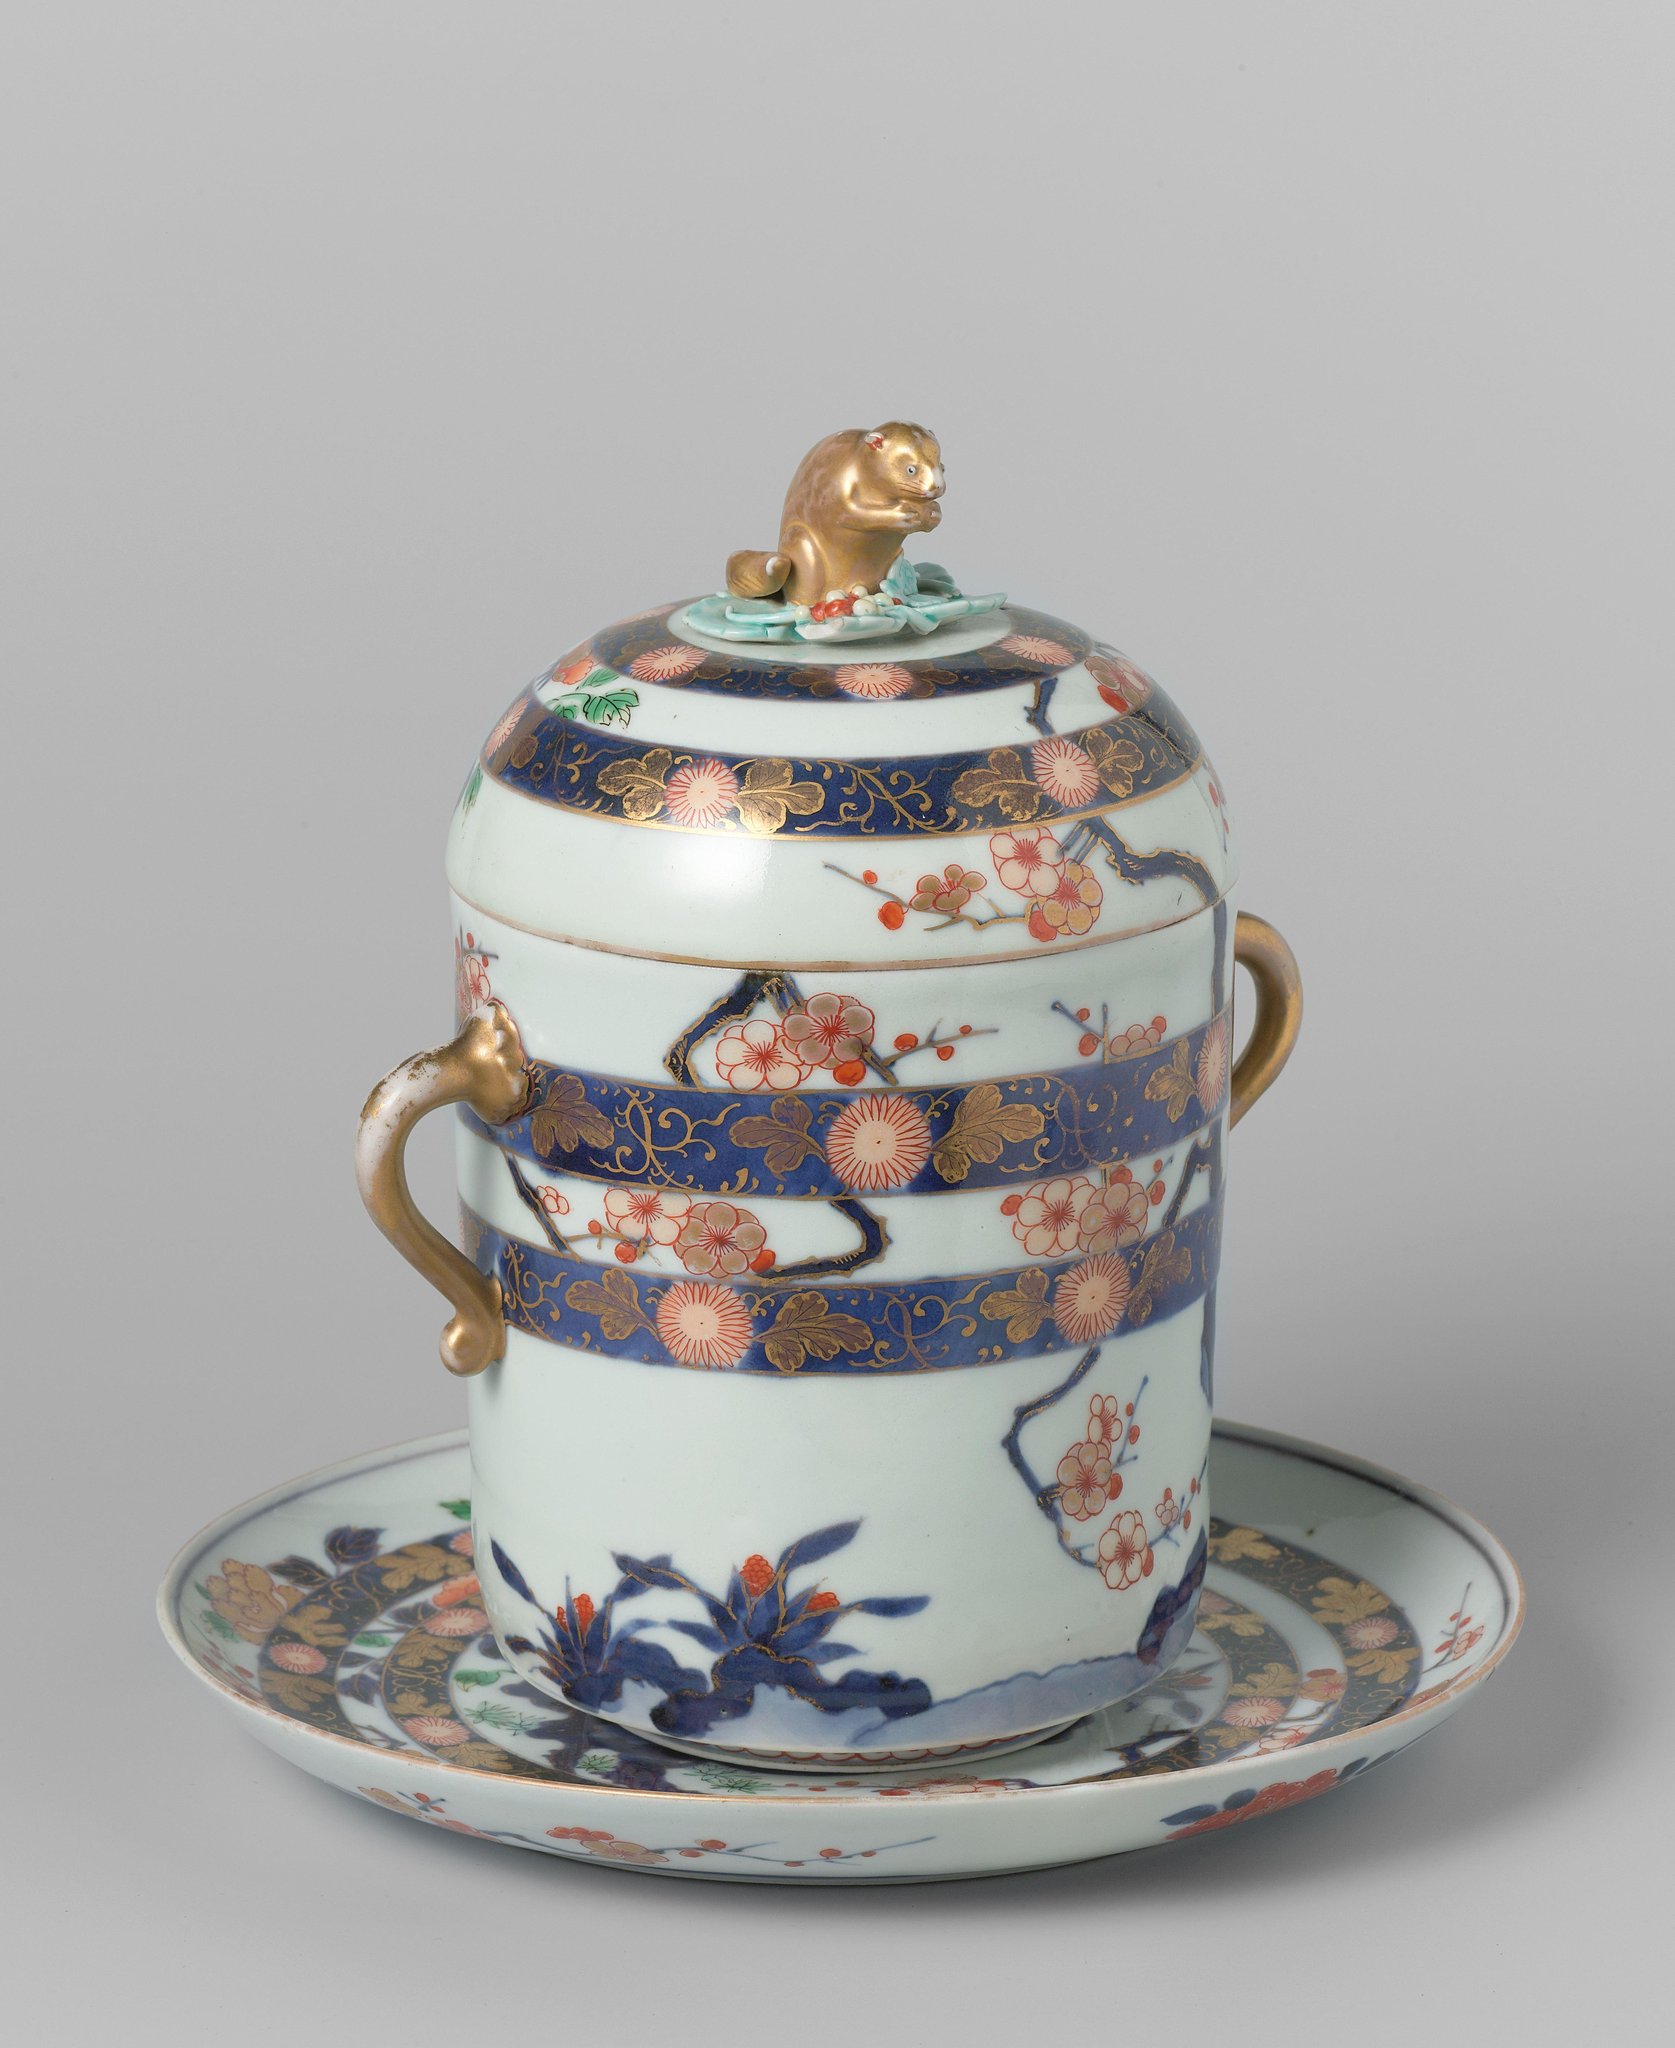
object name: lid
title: Covered jar and saucer with flowering plants and floral scrolls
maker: Anonymous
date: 1700-1720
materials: cobalt, glaze, gold, paint, porcelain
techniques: firing, forming, gilding, turning, vitrification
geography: japan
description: Hoge pot met rechte wanden en een hoge, bolle deksel. Twee kleinde S-vormige oren en een dekselknop die is gemodelleere in de vorm van een eekhoorn. Met bijpassende schaal. Beschilderd in onderglazuur blauw, rode, groene en gele emails en goud op het glazuur met bloeiende boomtakken die zich over de wand van de pot en de deksle uitstrekken. het decor wardt onderbroken door vier smalle, horizontale blauwe banden met gestileerde bloemranken. De onderschotel heeft hetzelfde decor. Imari-porselein.